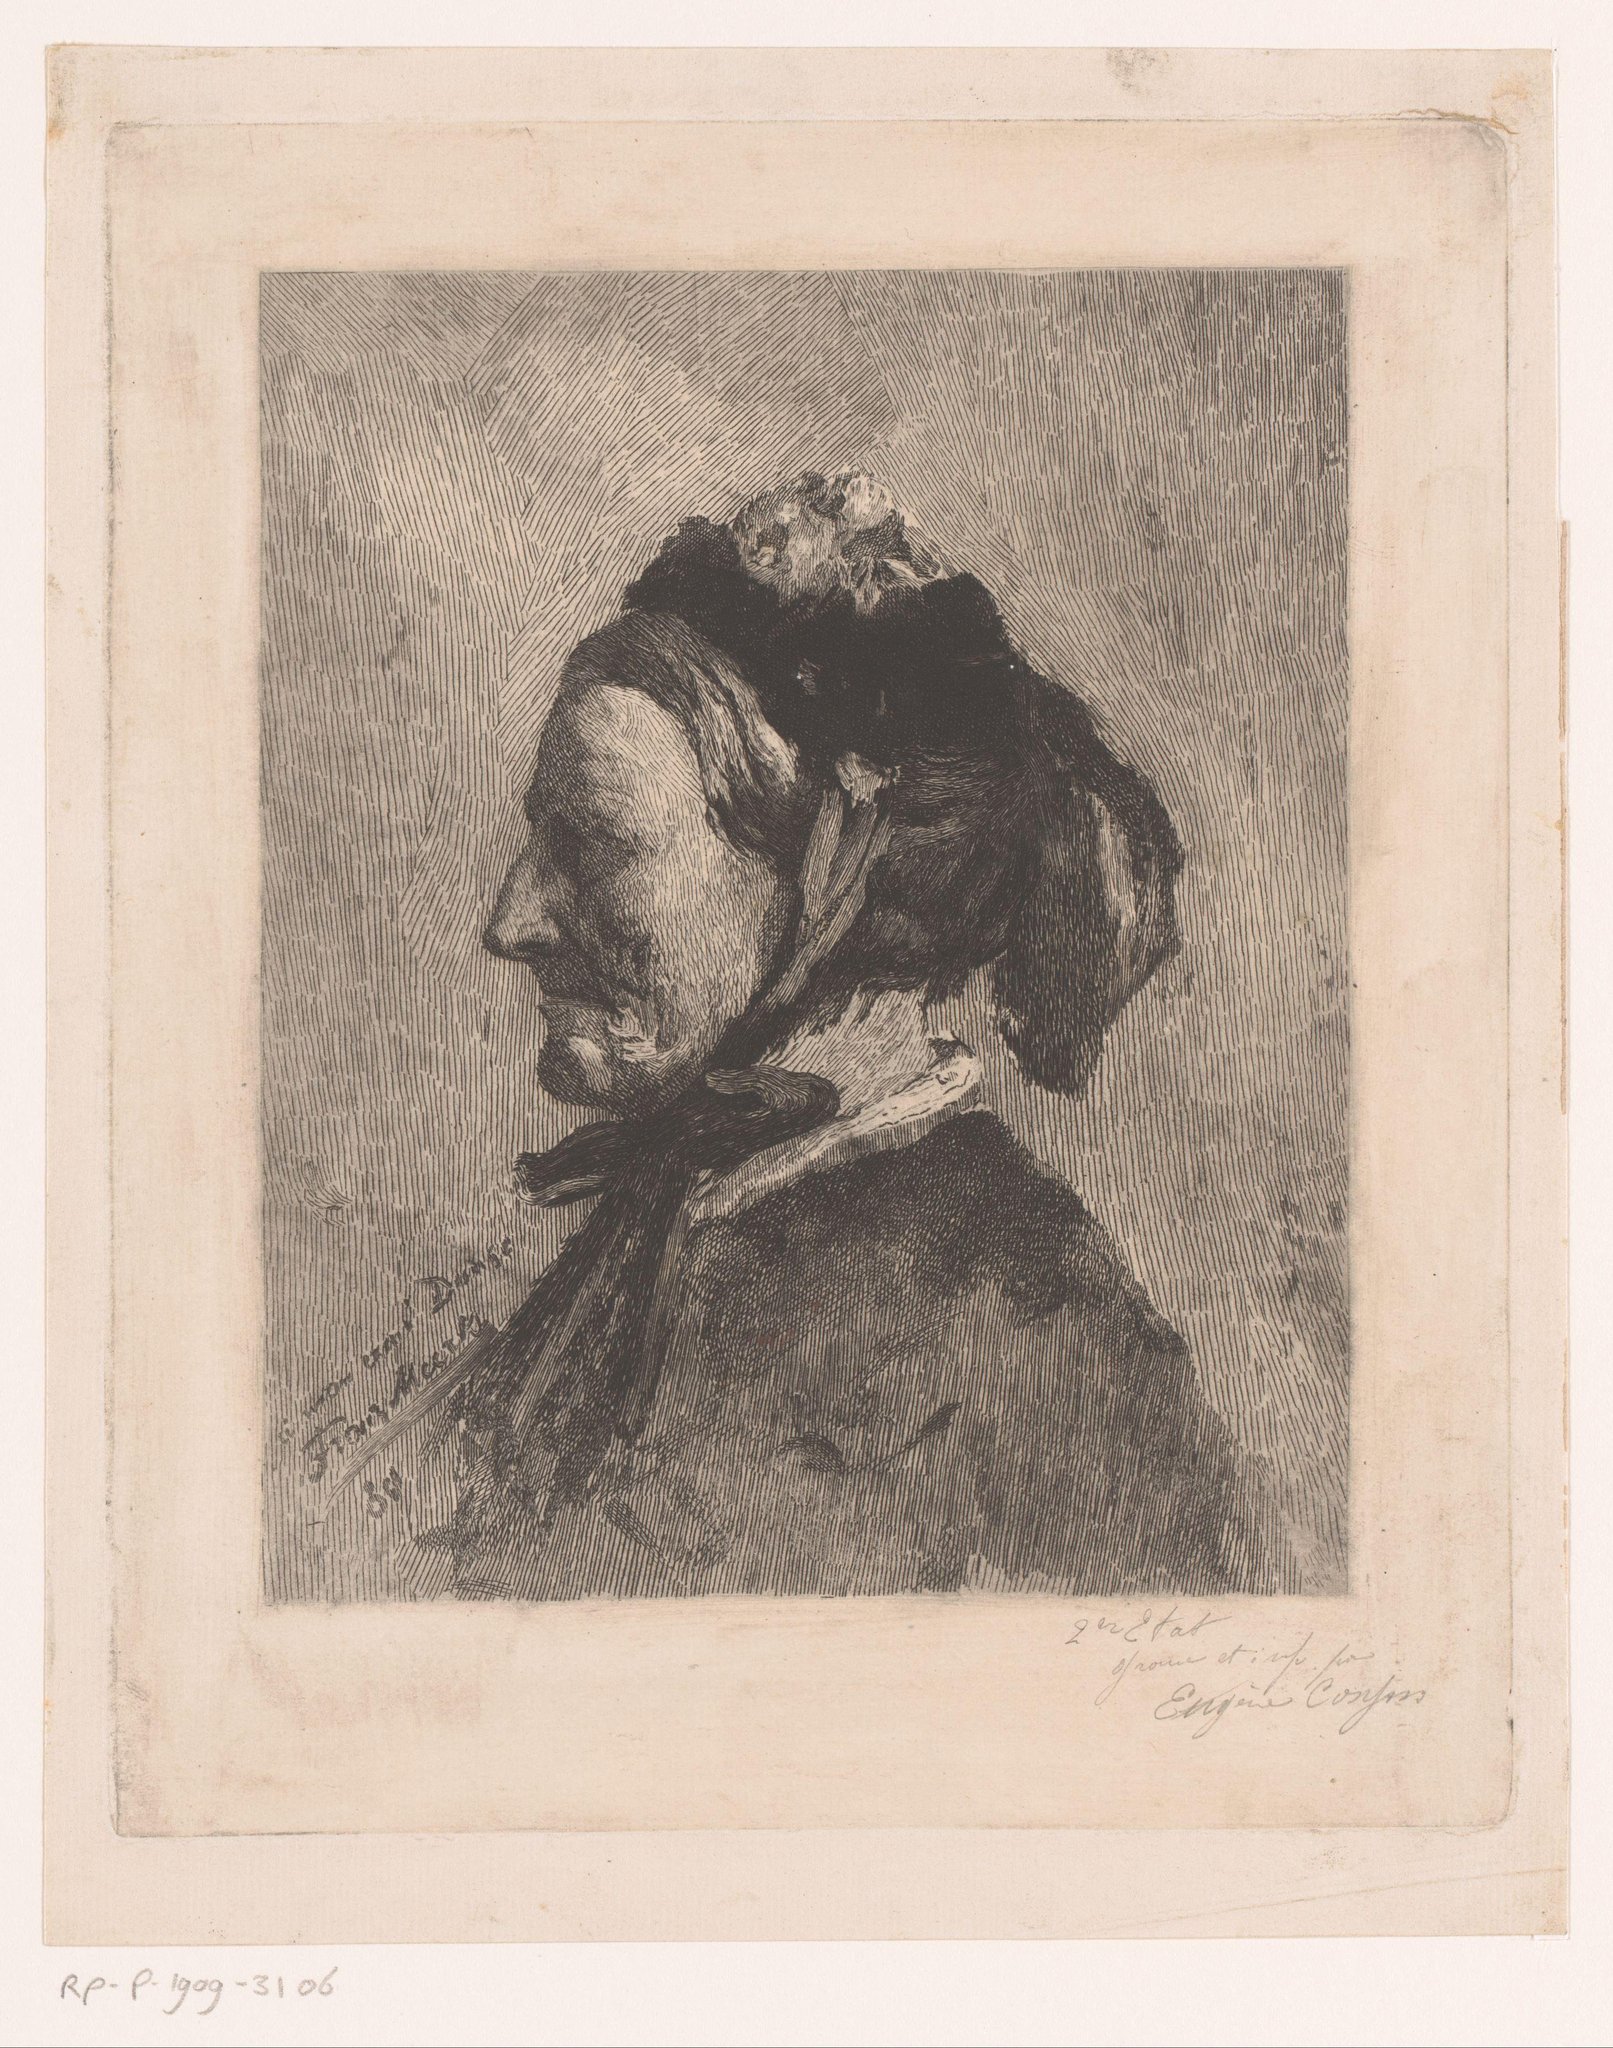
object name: print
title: Portret van een onbekende oude vrouw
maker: eugène cosyns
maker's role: print maker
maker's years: 1862-1909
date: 1880-1909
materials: paper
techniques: etching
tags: historical persons, old woman (+ sideview, profile)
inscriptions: collector's mark: Lugt 2228, inscription: ‘2e Etat grave et imp par Eugène cosyns’